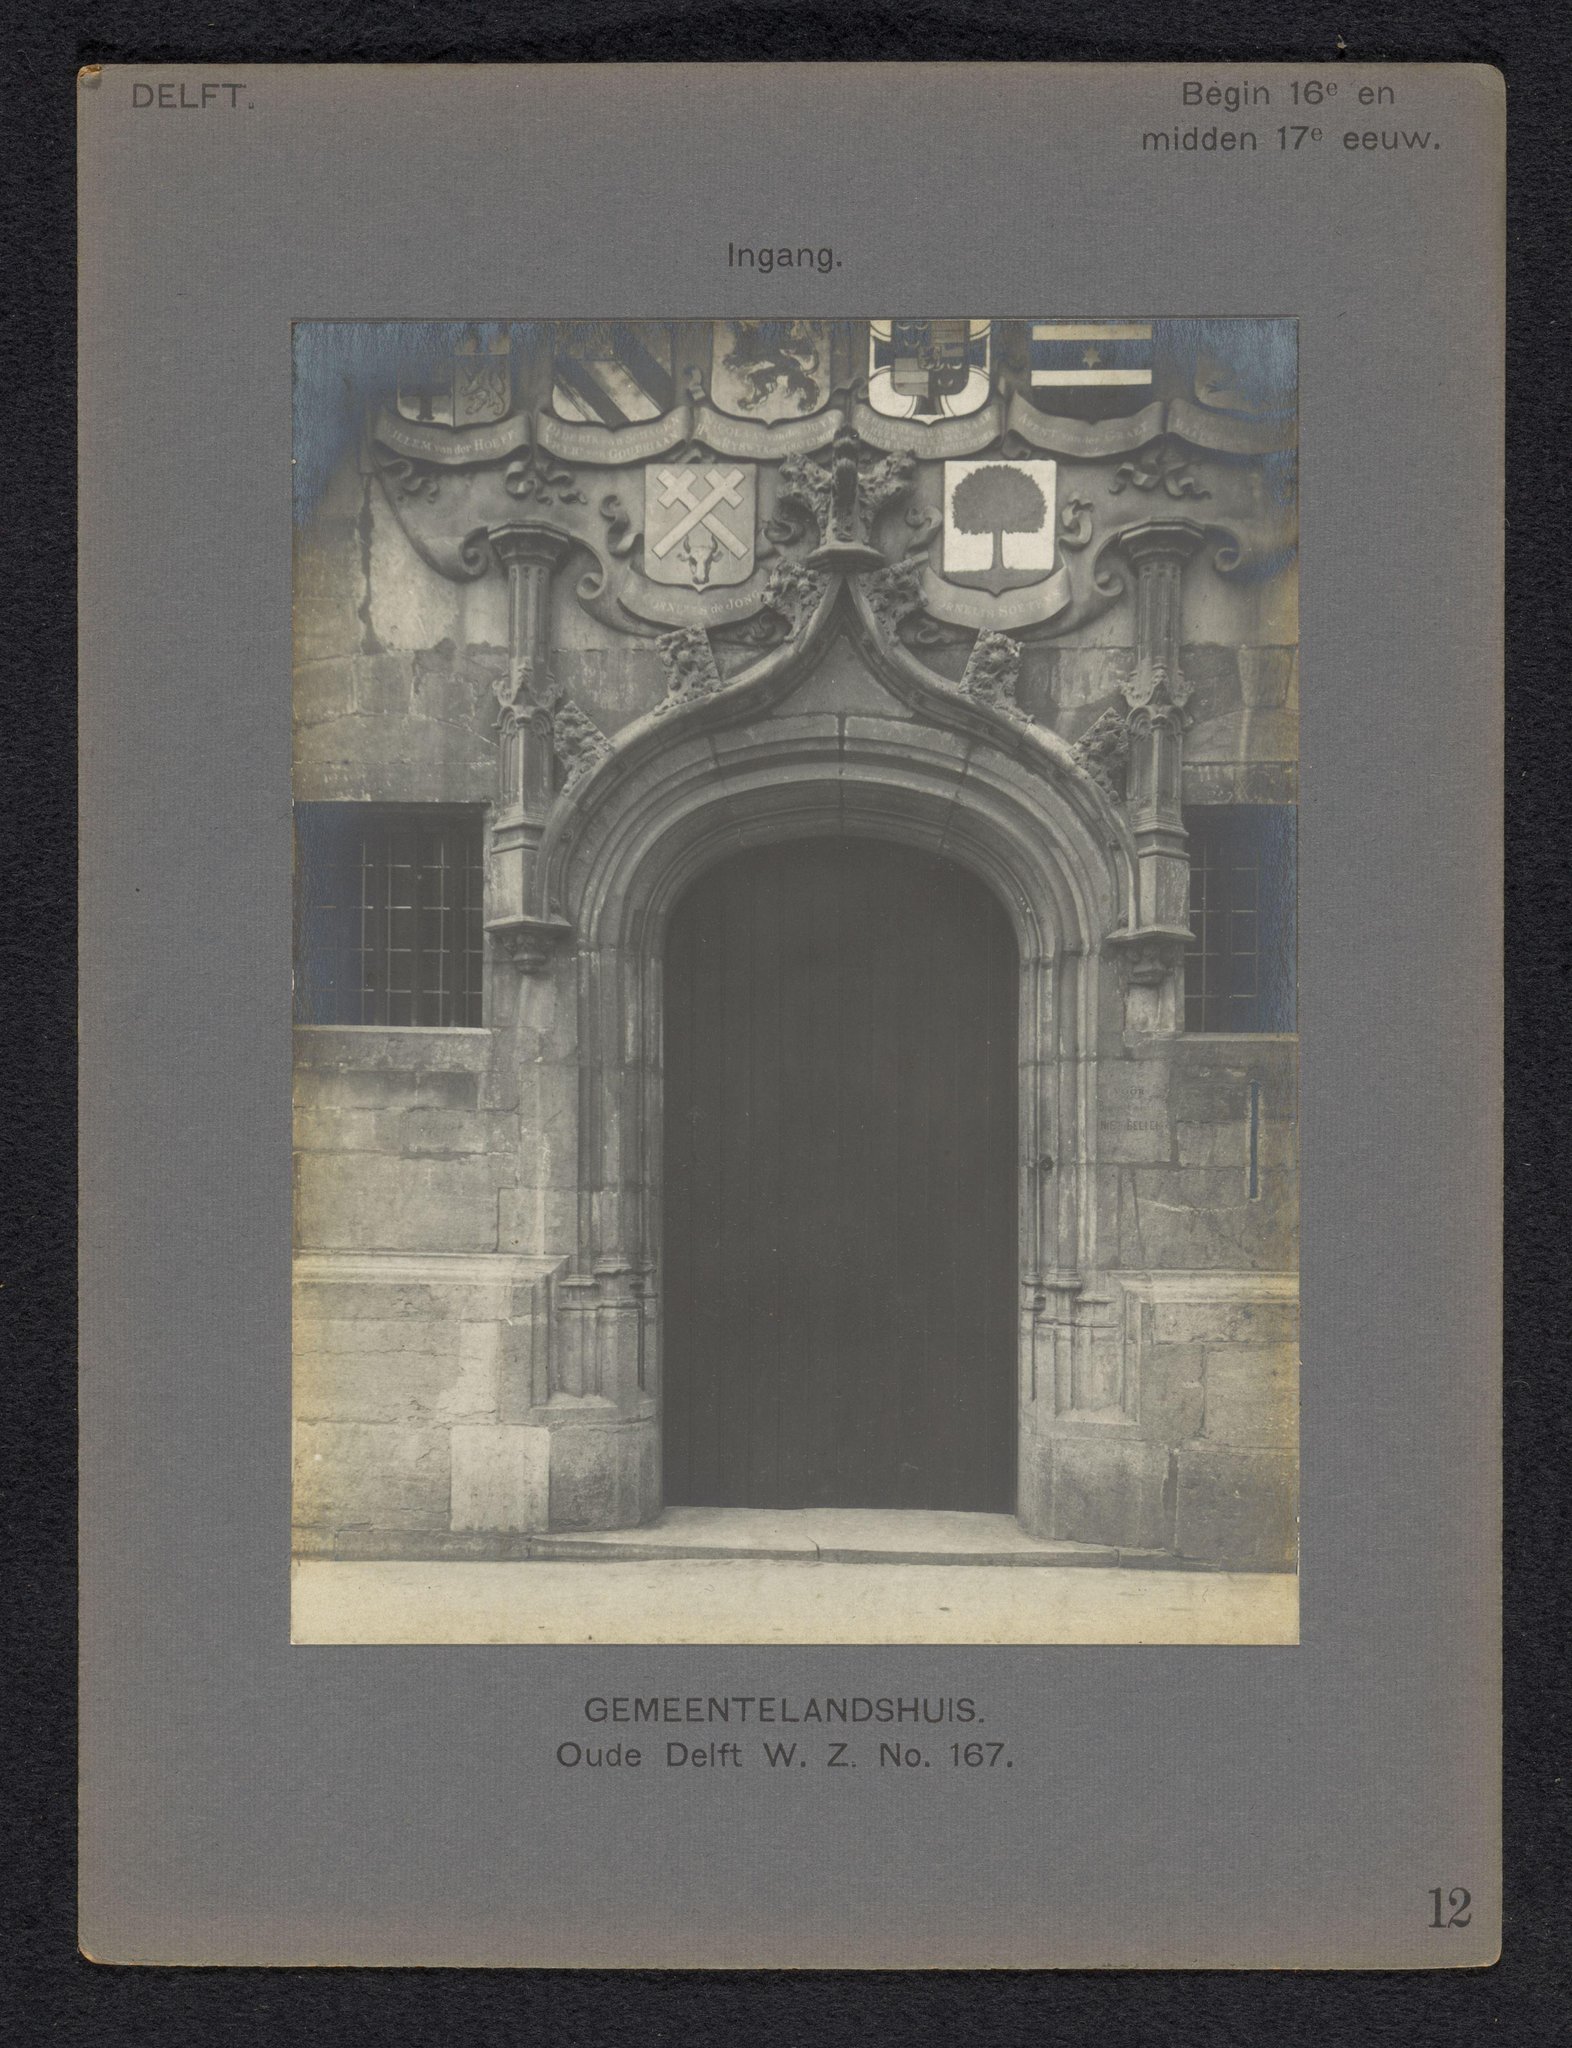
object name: photograph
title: Toegangspoort van het Gemeenlandshuis aan de Oude Delft in Delft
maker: Anonymous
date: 1900-1904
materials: cardboard, photographic support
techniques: gelatin silver print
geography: delft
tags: gate, entrance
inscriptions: number: ‘12’, inscription: ‘Het recht van reproductie dezer photo's wordt door den Uitgever voorbehouden.’, inscription: ‘Delft. Begin 16e eeuw en midden 17e eeuw.’